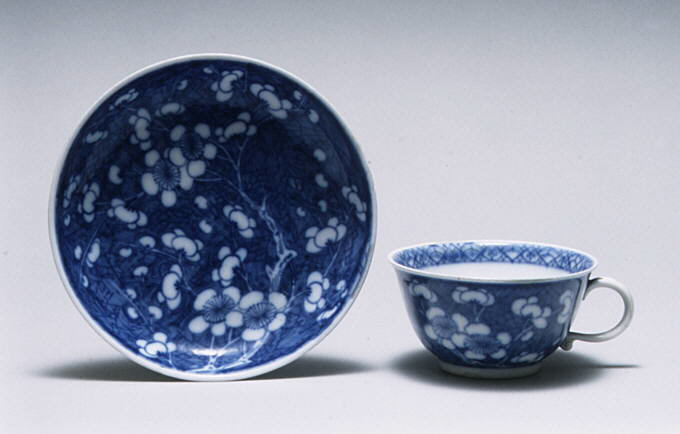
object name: cup and saucer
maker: meissen manufactory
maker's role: manufactory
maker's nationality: german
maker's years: 1710-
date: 1740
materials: hard paste porcelain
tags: flowers